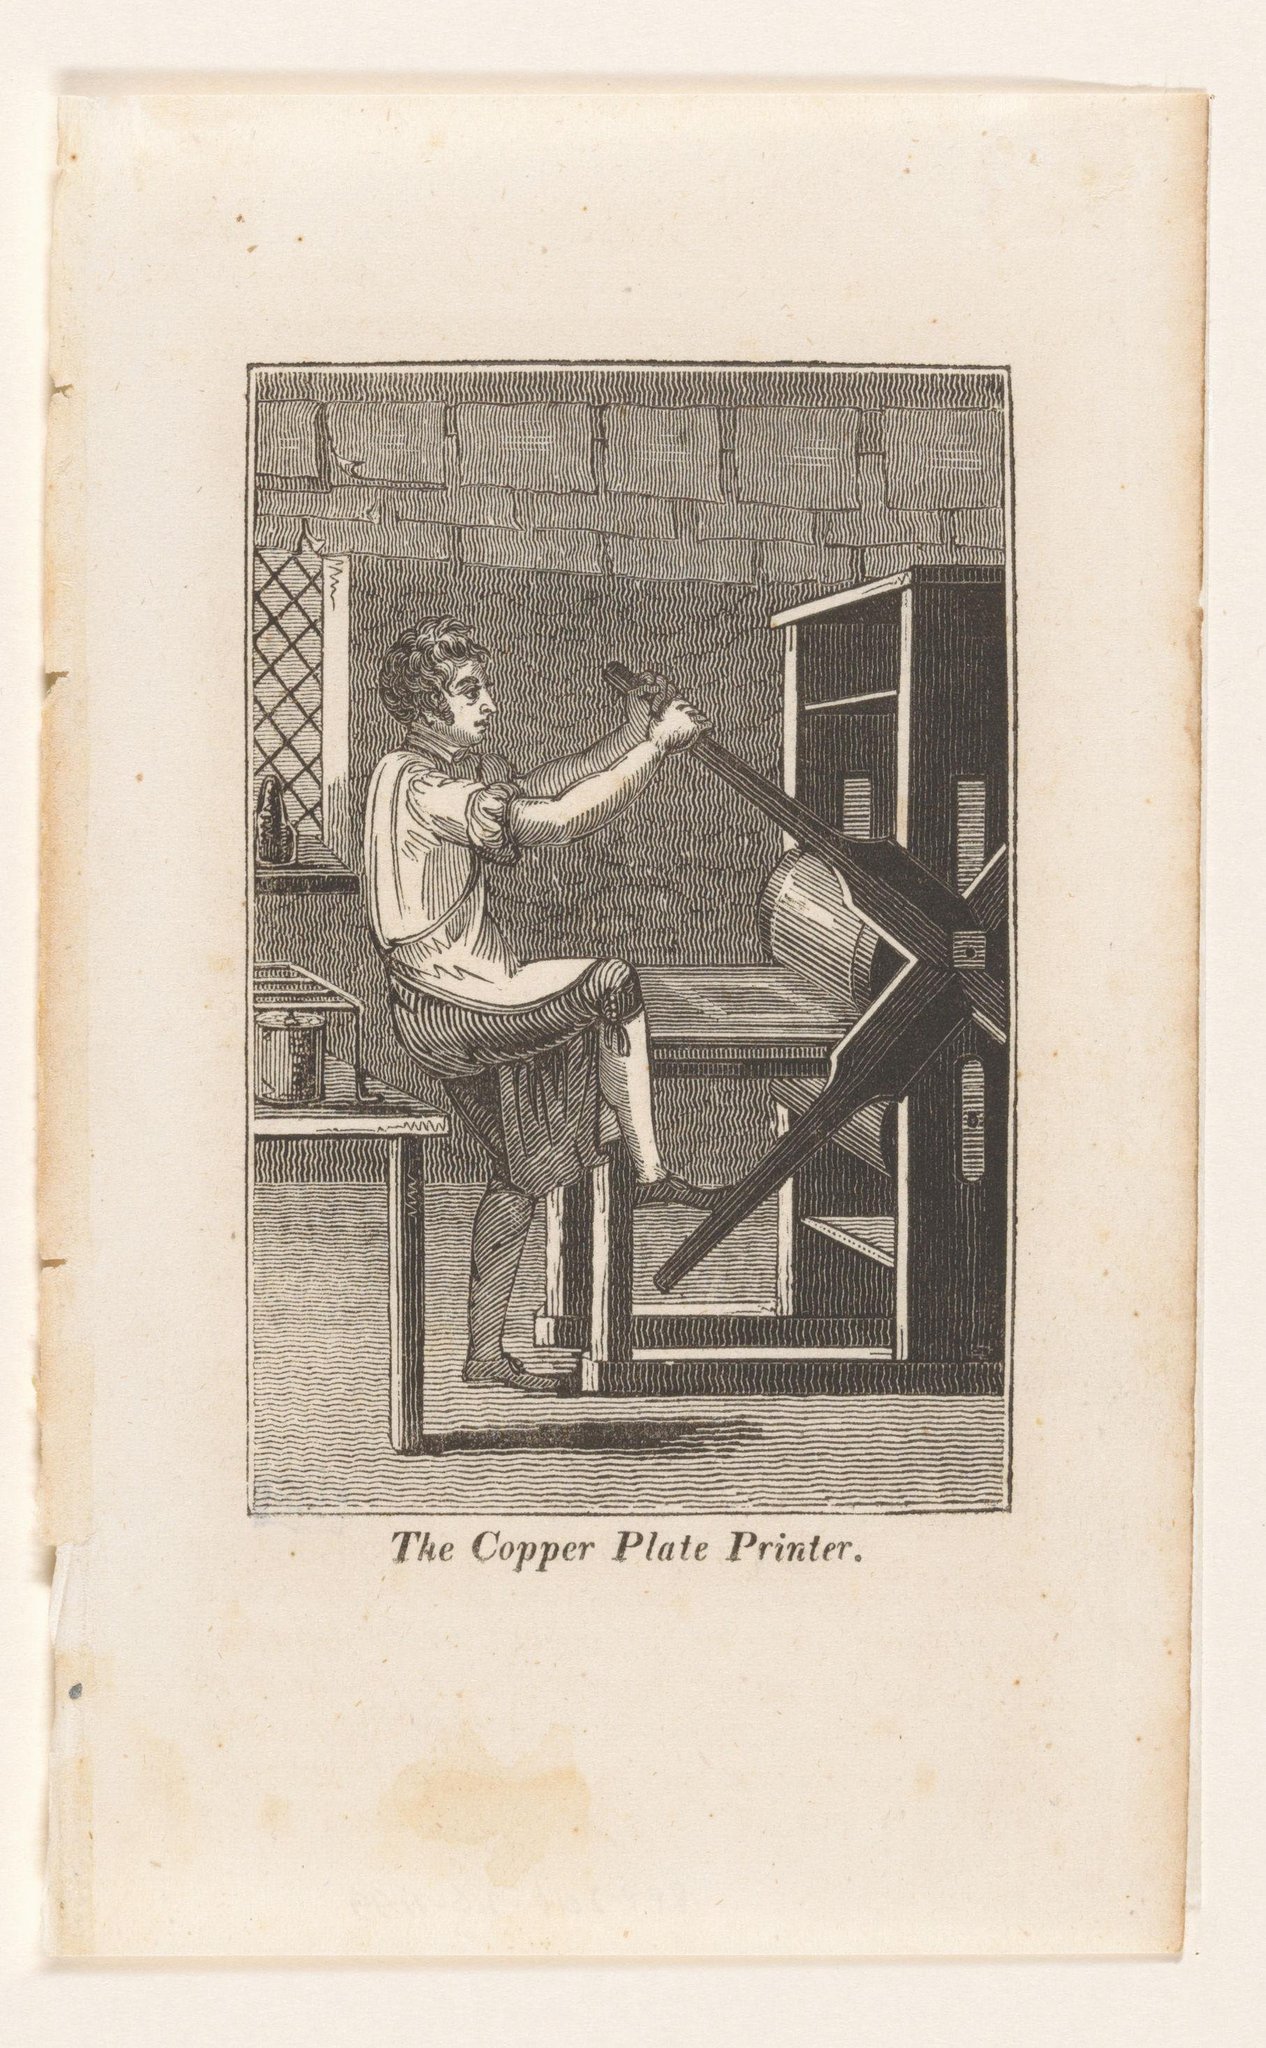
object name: book illustration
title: Plaatdrukker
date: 1821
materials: paper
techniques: engraving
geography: london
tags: printing press, tools, implements of graphic artist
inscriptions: collector's mark: Lugt 4780, collector's mark: Lugt 2228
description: Prent afkomstig uit: The Book of English Trades, and Library of the useful Arts. Londen: Richard Philips and Co., 1821, p. 121-121. De prent is een kopie van de gravure die werd gebruikt voor eerdere edities van deze publicatie.